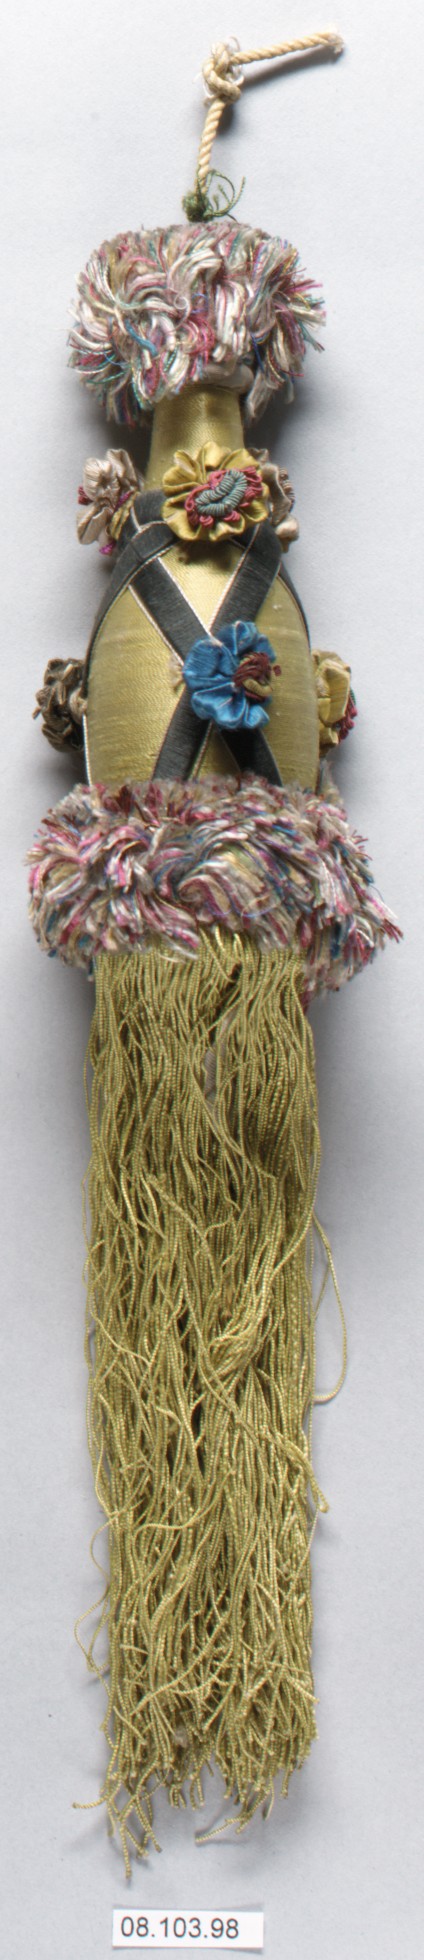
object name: tassel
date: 1701-1800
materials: silk